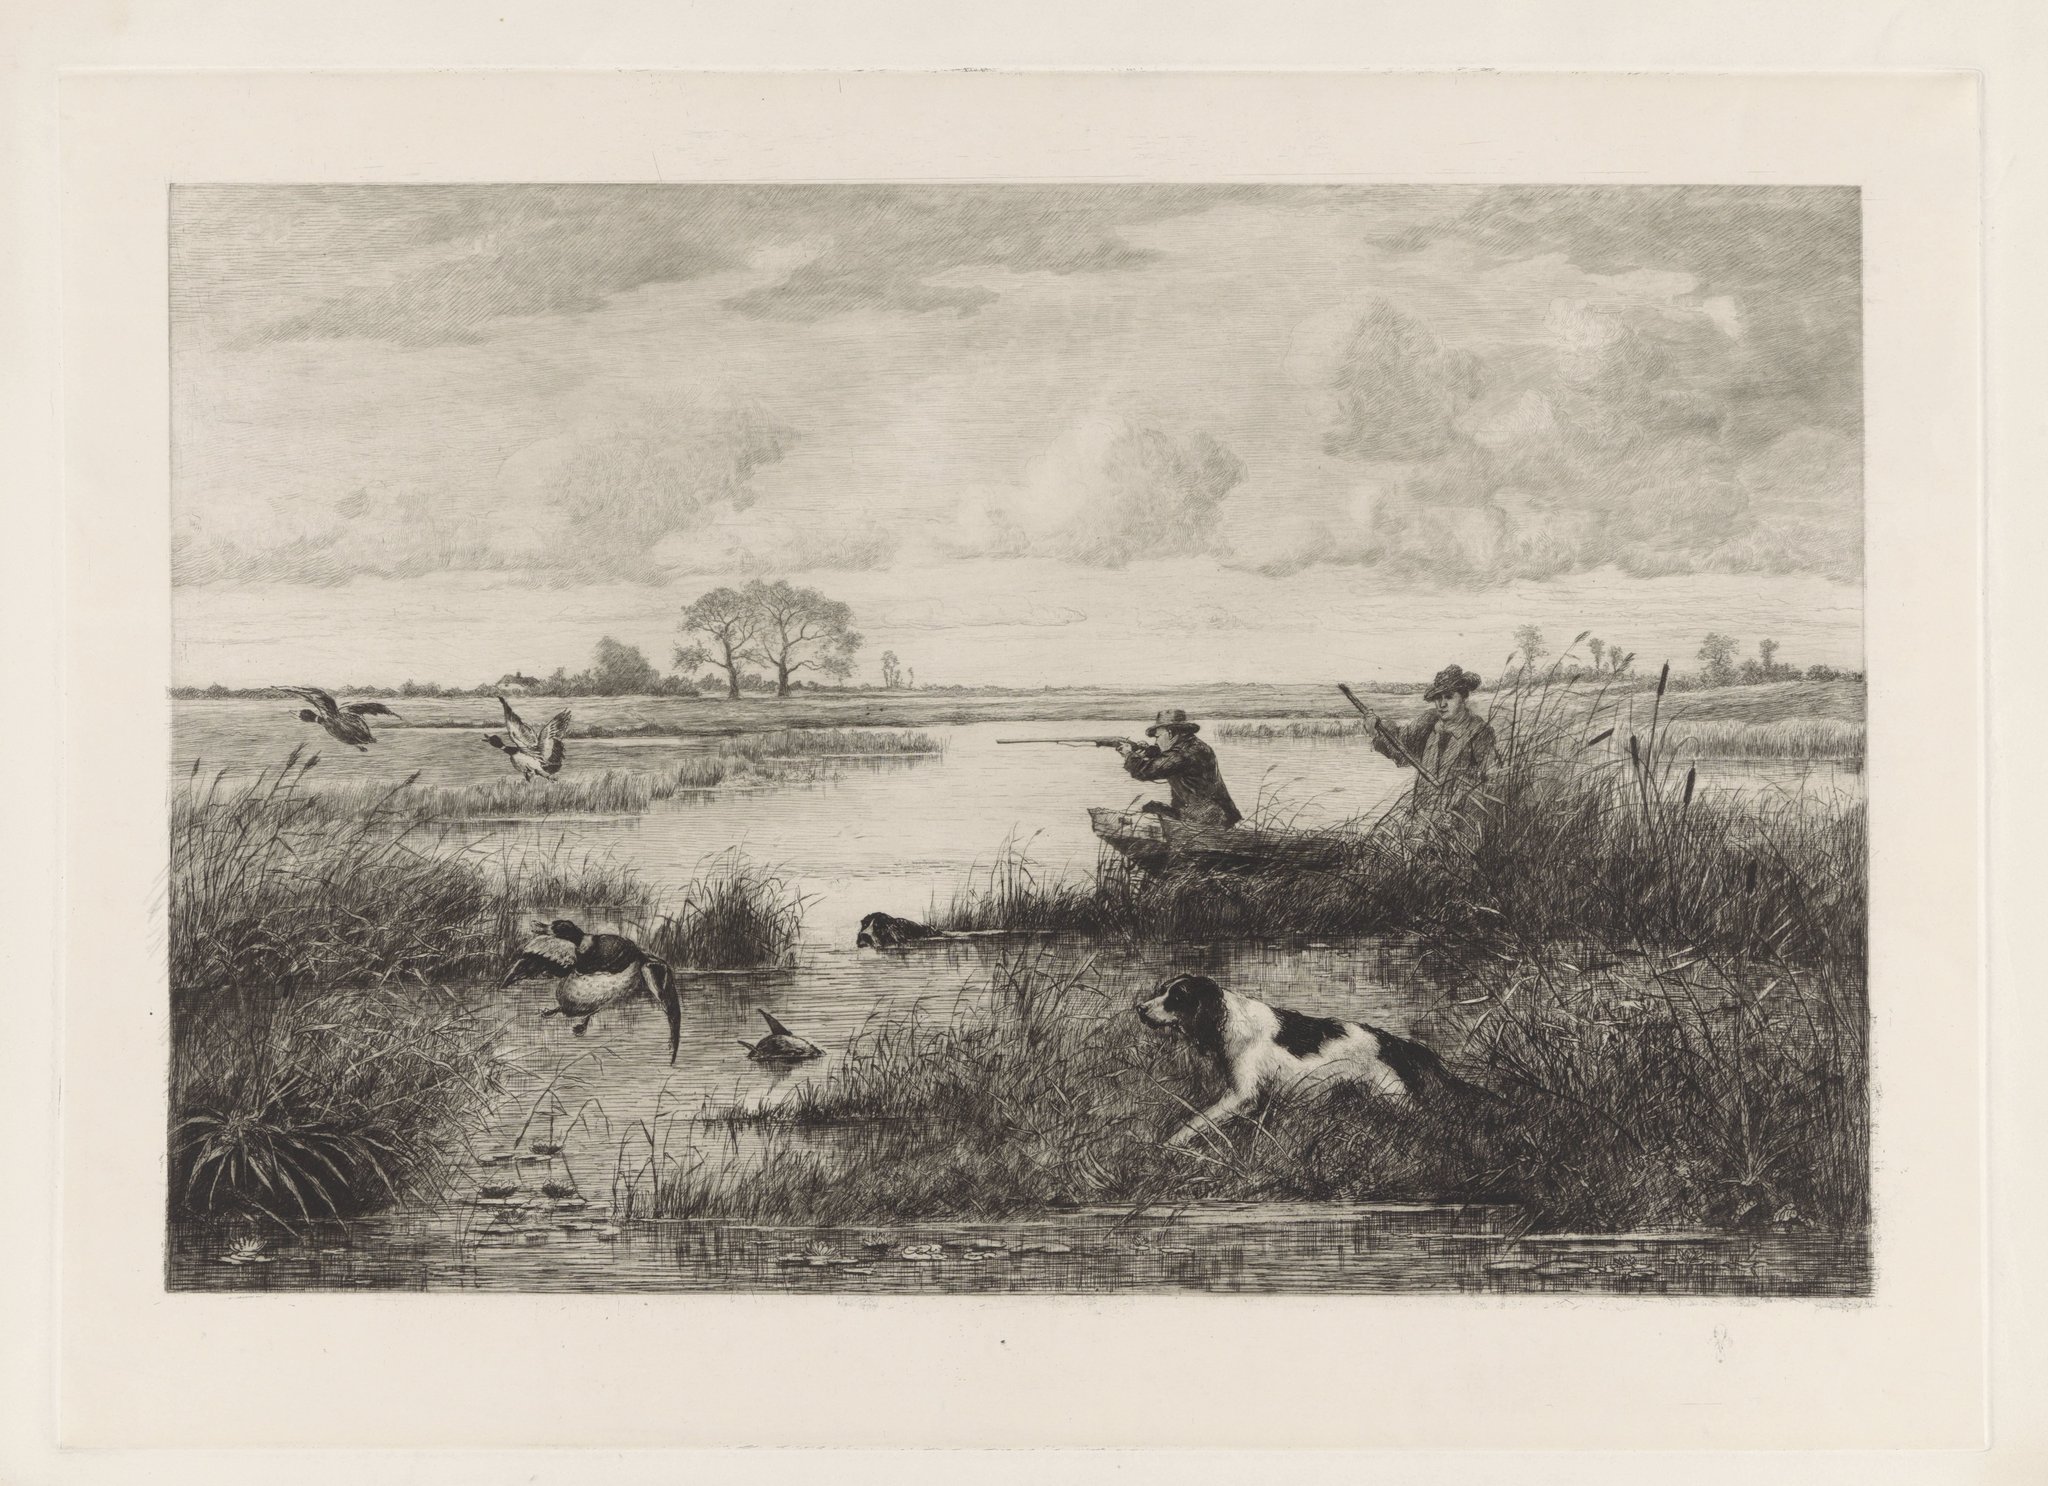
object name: print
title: Eendenjacht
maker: elias stark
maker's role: draughtsman, print maker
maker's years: 1849-1933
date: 1859-1891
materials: paper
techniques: etching, intaglio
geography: nieuwer-amstel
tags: bird hunting, swamps and polders, dog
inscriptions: collector's mark: Lugt 2228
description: Achter het riet ligt een schuit waarin een jager, die zijn geweer aanlegt, en een man, die de schuit voortboomt. De jager richt op twee eenden, die naar links vliegen. In het water een zwemmende hond en een geschoten eend. Op de voorgrond een hond tussen het riet.